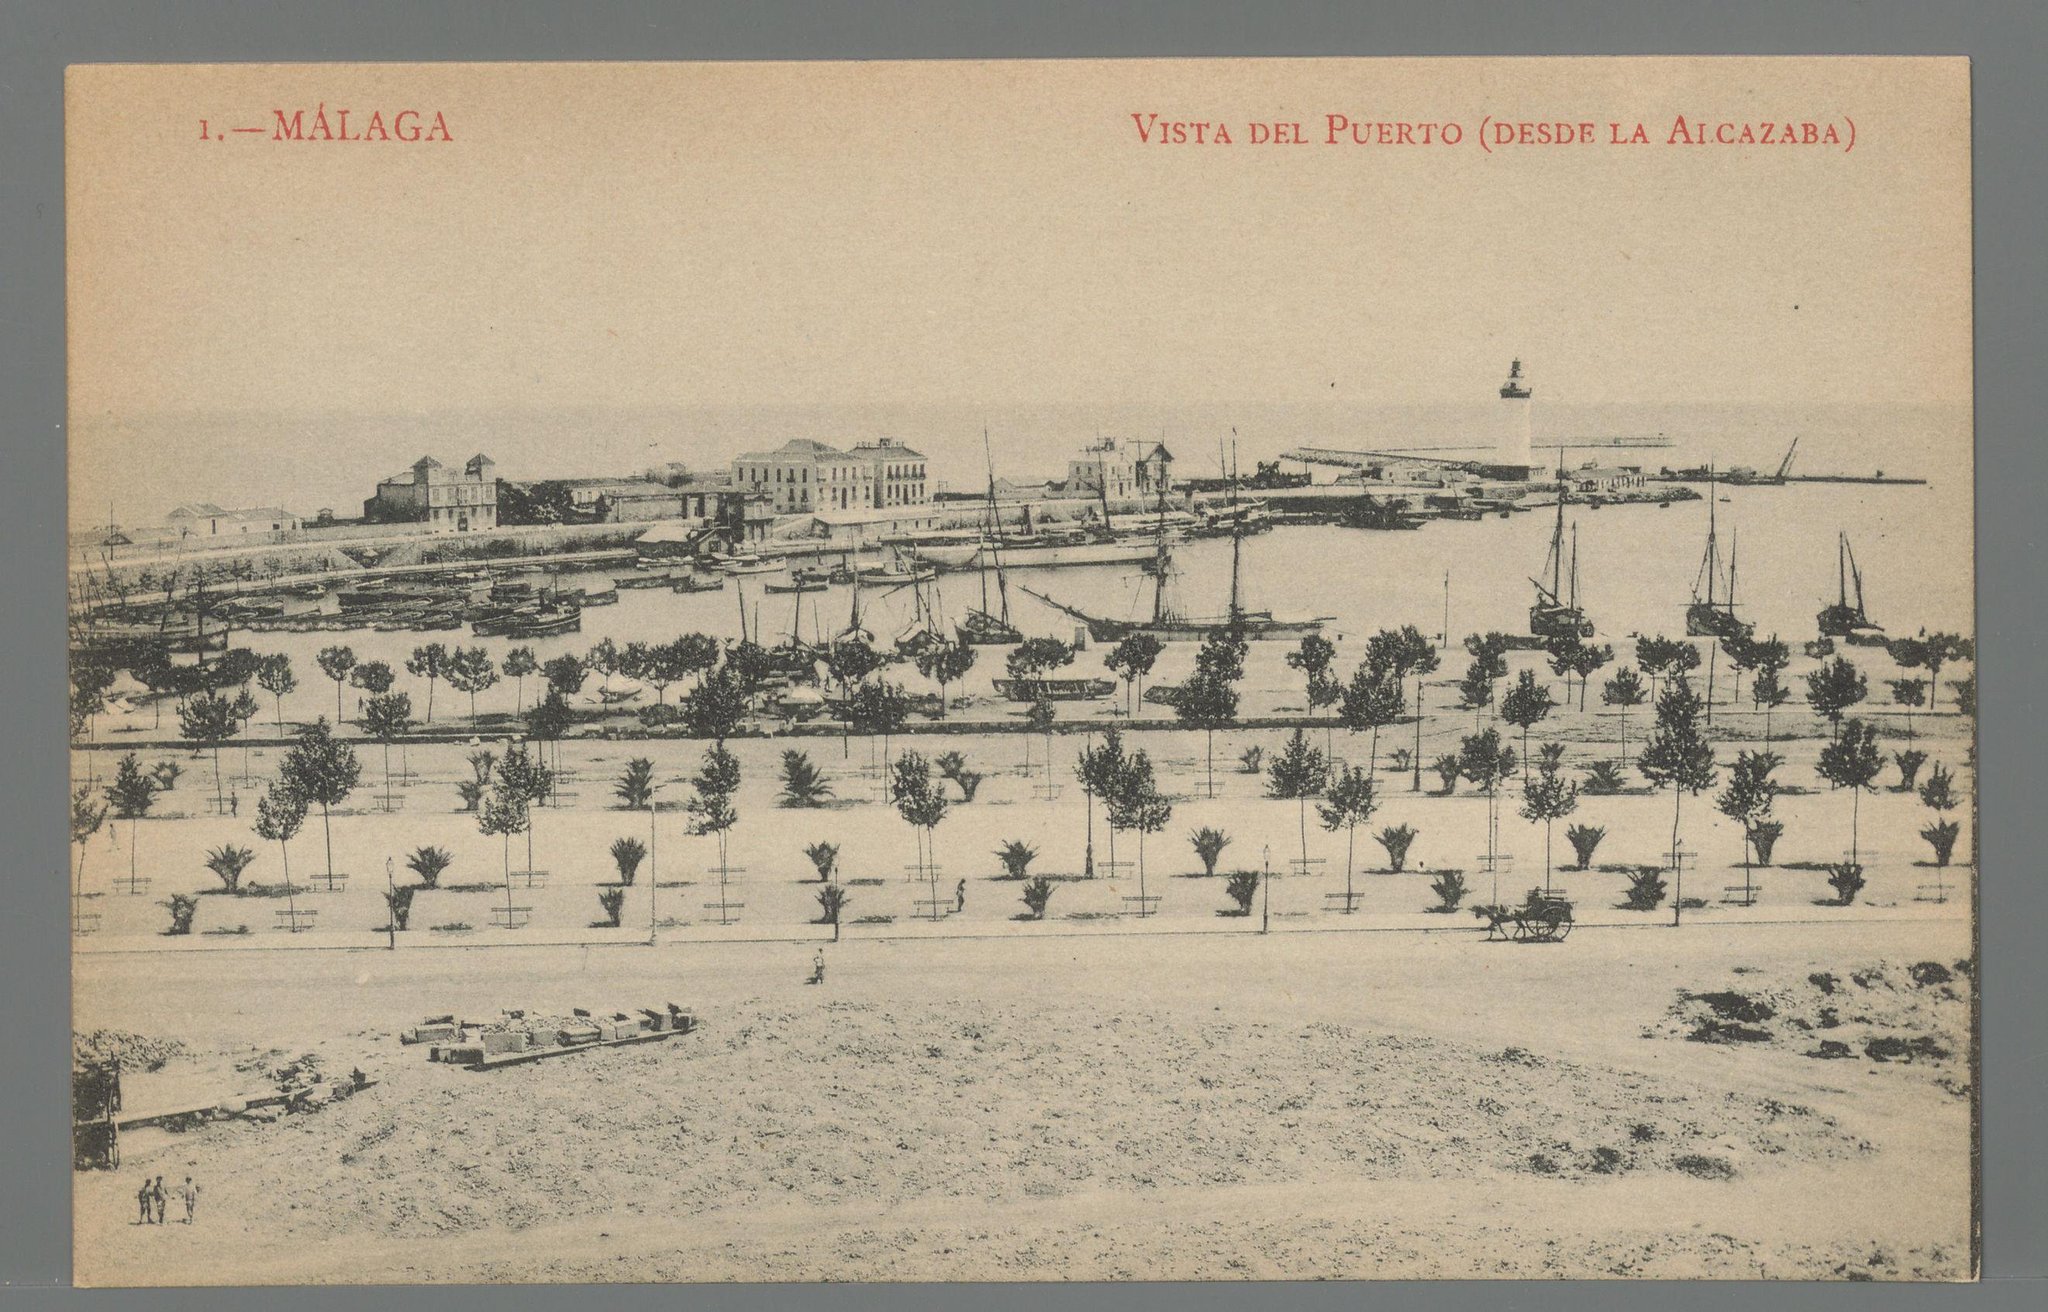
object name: ansichtkaart, prentbriefkaart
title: Málaga. Vista del Puerto (desde la Alcazaba)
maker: Anonymous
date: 1906-1930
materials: cardboard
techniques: photograph, writing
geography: málaga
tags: harbour